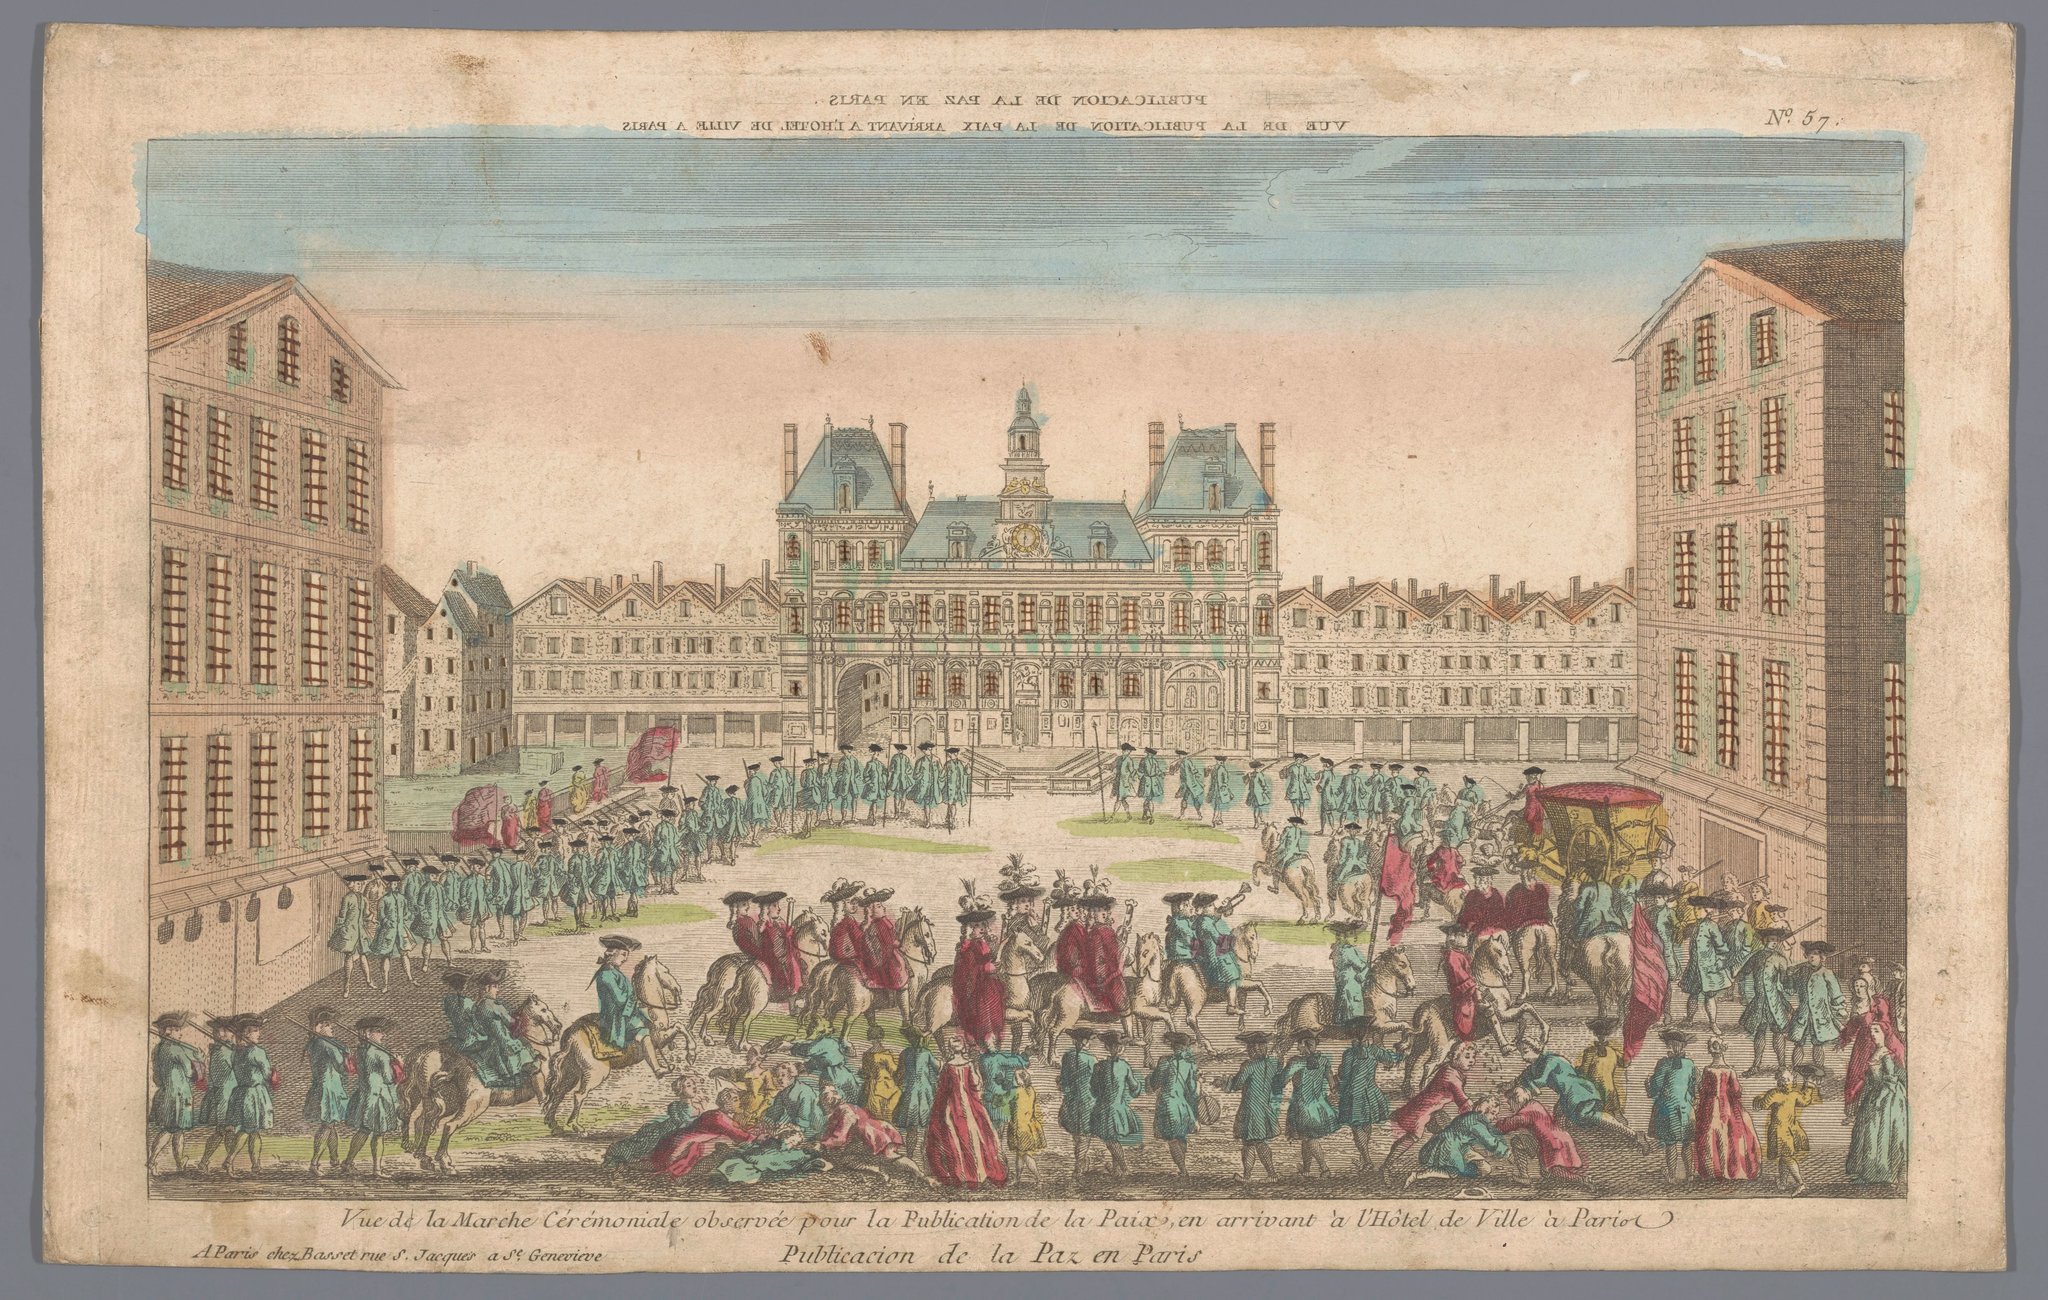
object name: opticaprent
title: Publicacion de la paz en Paris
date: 1700-1799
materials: cardboard, paper, watercolor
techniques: brush, cutting, etching, perforating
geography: france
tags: proclamation of peace, townhall, military parade, pageant, square, place, circus, etc. (+ city(-scape) with figures, staffage)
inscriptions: collector's mark: Lugt 2233